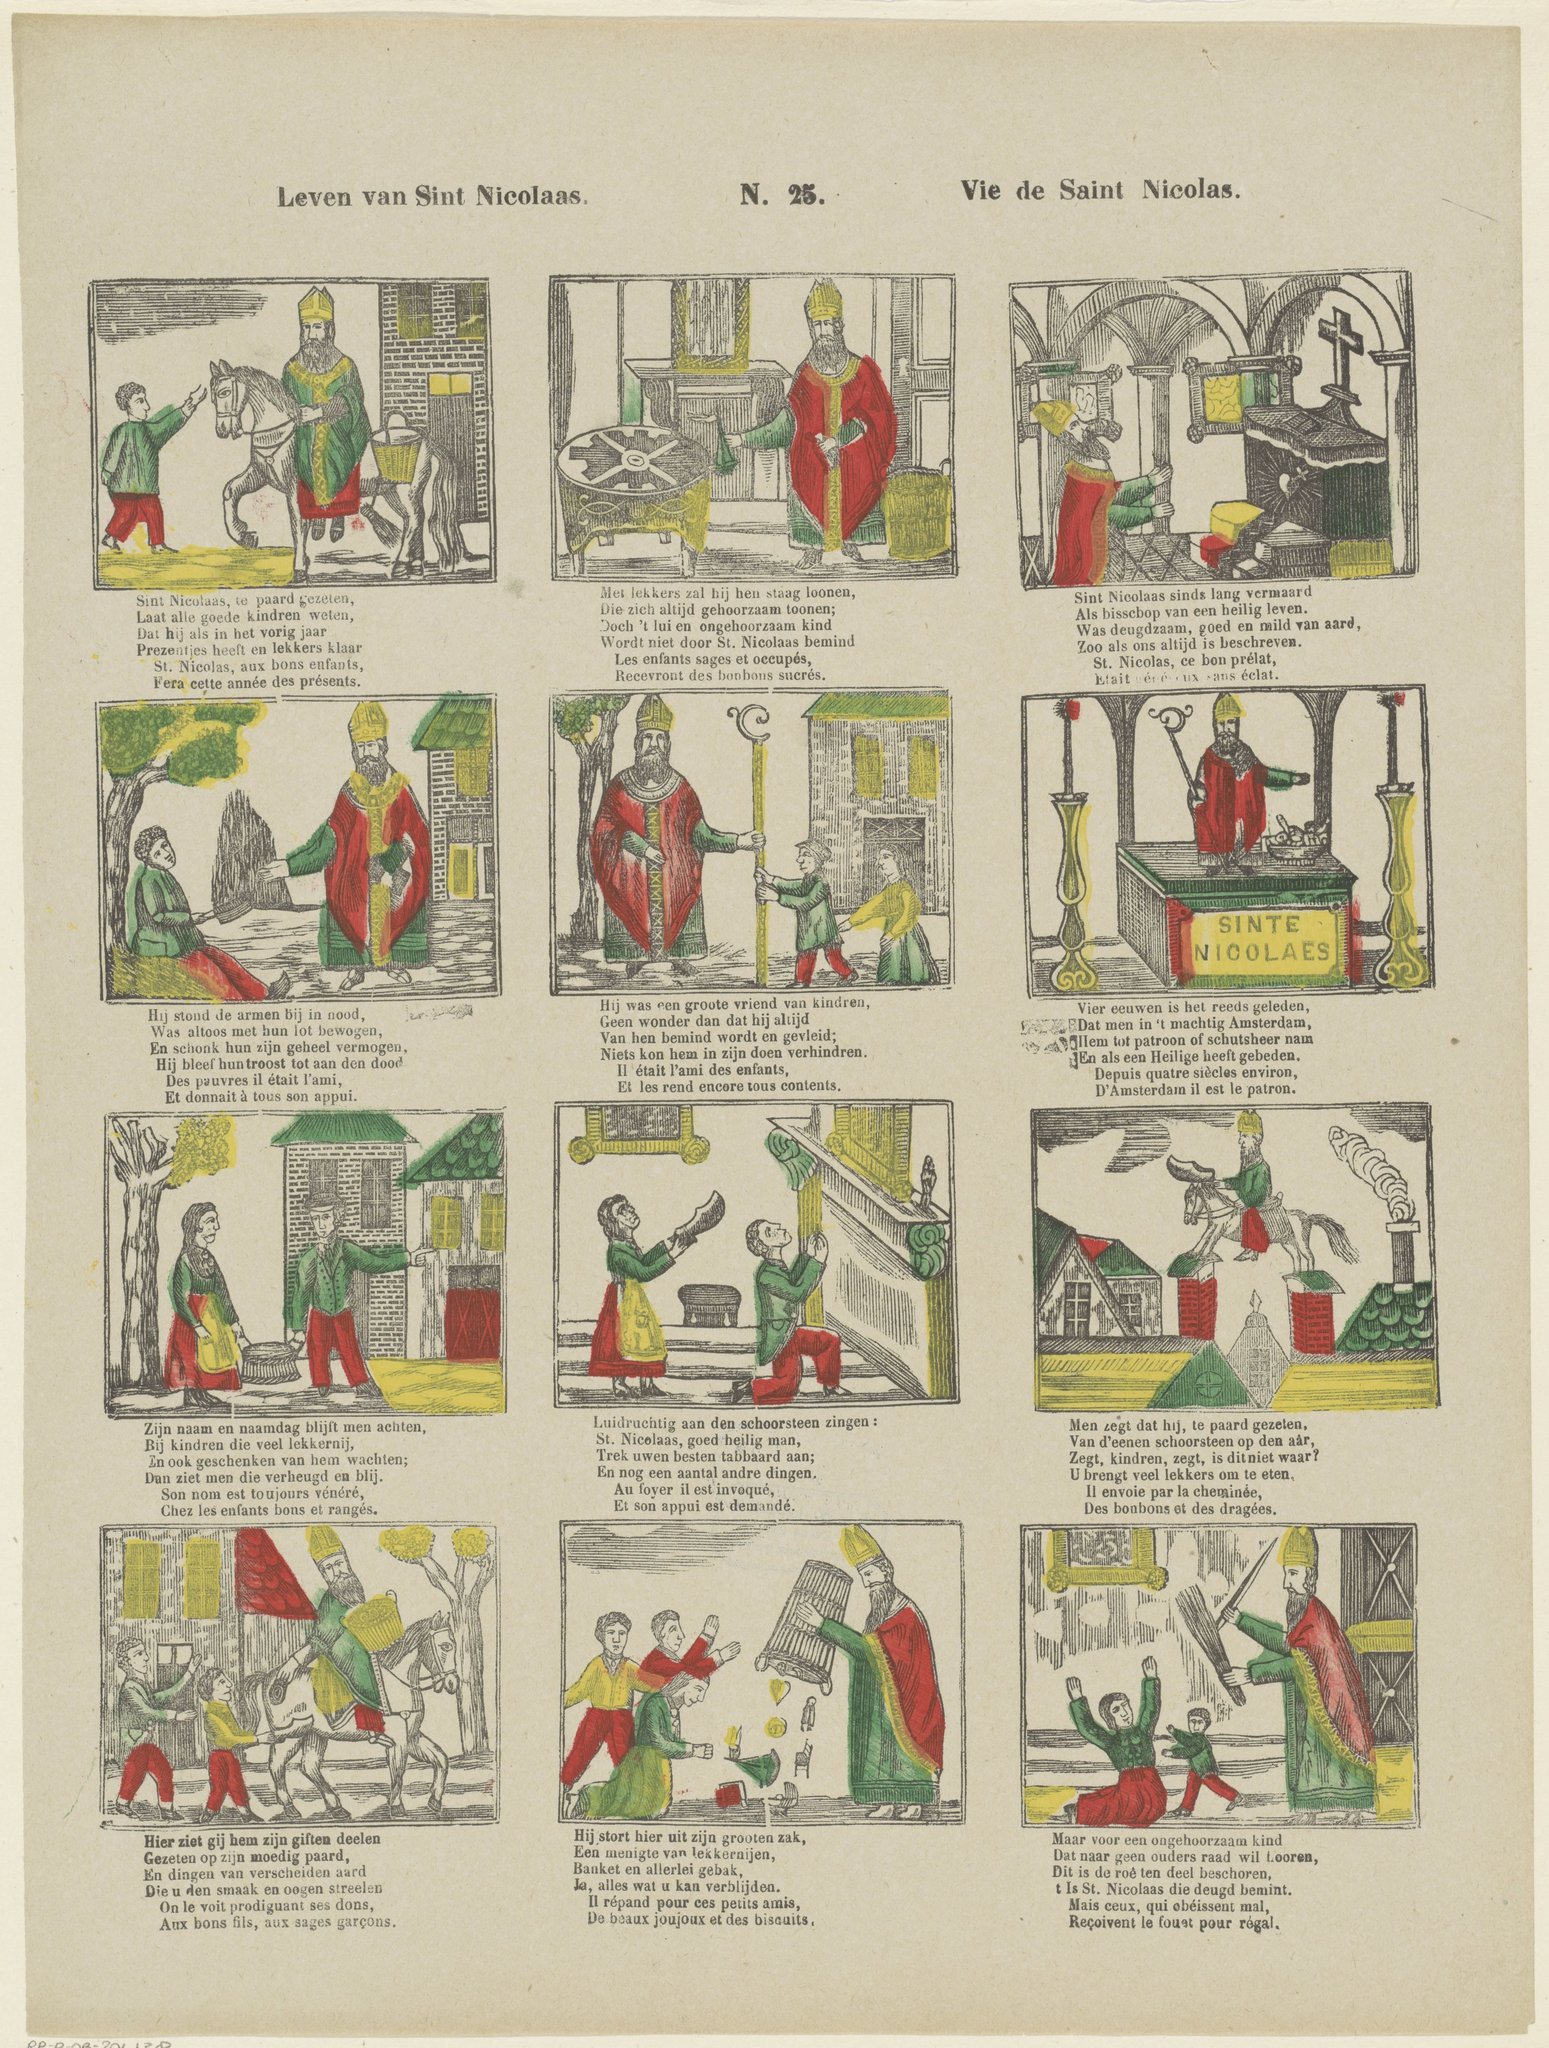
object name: popular print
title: Leven van Sint Nicolaas / Vie de Saint Nicolas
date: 1866-1902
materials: paper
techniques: colour, letterpress printing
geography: turnhout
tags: the bishop nicholas of myra (or bari); possible attributes: anchor, boat, three golden balls (on a book), three purses, three children in a tub, three maidens, festivities on st. nicholas (eve) (december 5)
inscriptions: collector's mark: ‘Edw. Ipers / Oever 27, / Antwerpen.’, collector's mark: Lugt 2760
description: Blad met 12 voorstellingen over het leven van Sint Nicolaas. Onder elke afbeelding een vierregelig vers in het Nederlands en een tweeregelig vers in het Frans. Genummerd midden boven: N. 25.